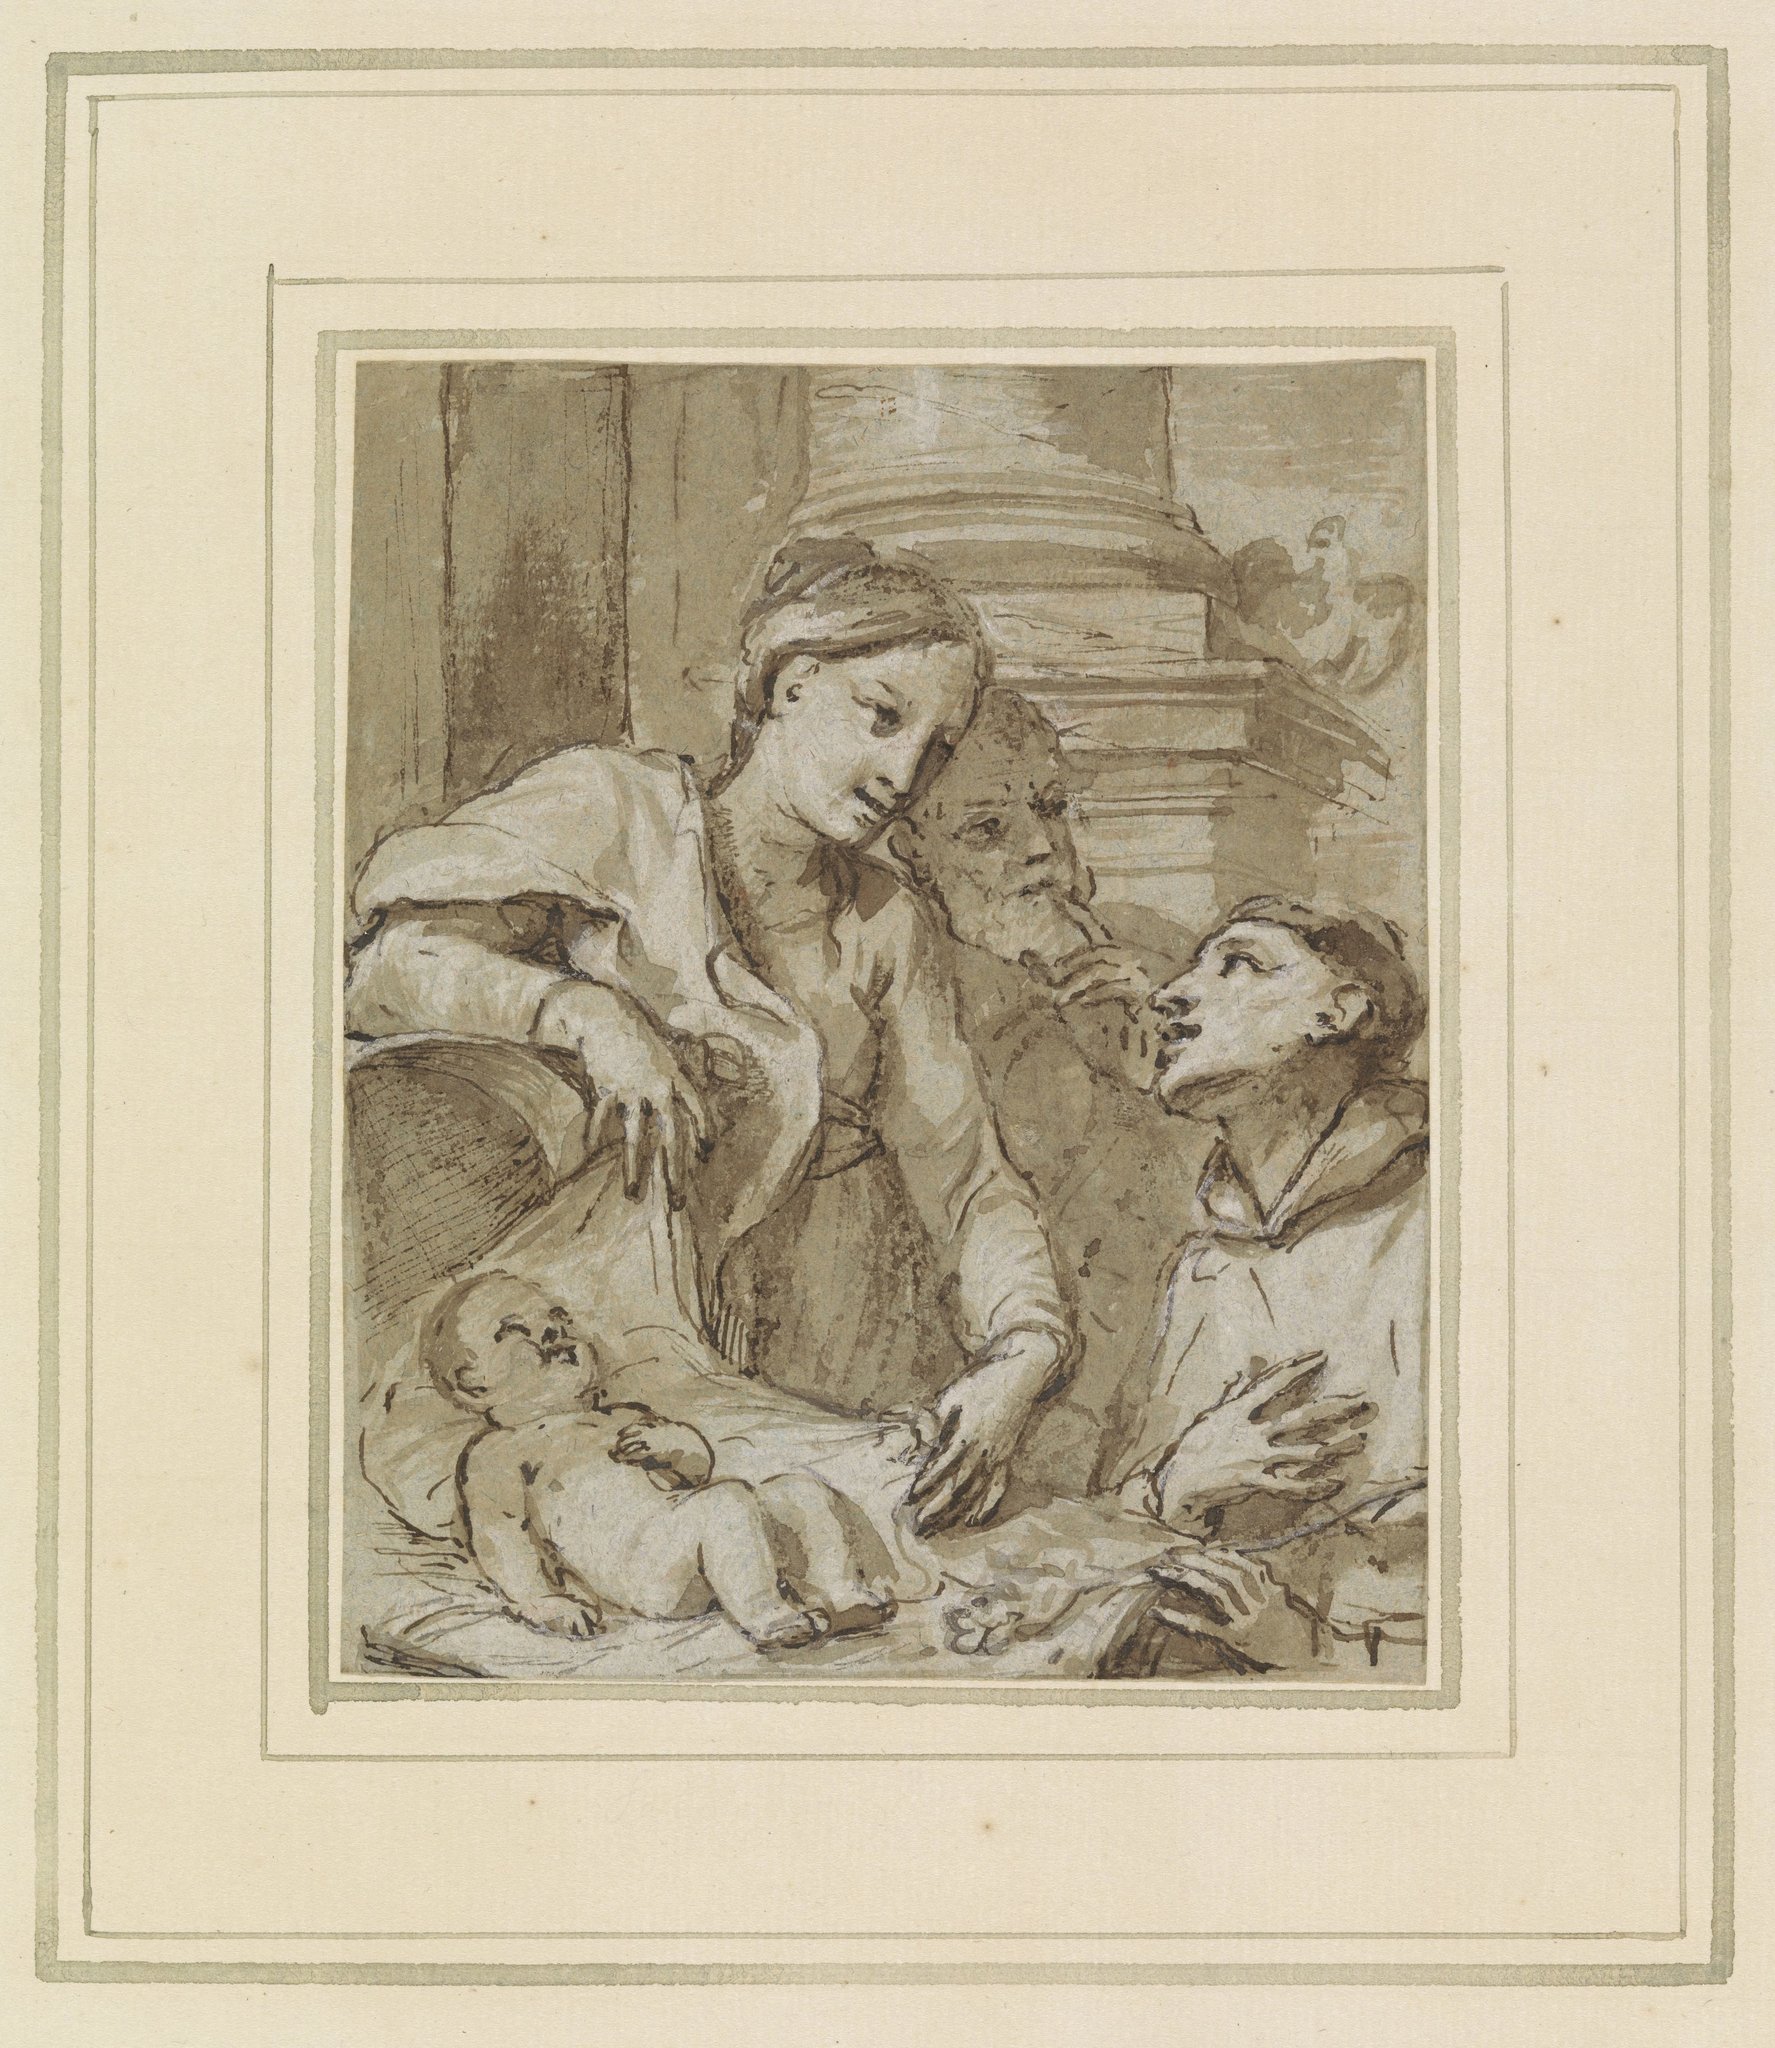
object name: drawing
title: Heilige Familie met de heilige Antonius van Padua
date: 1600-1699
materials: paint, ink, paper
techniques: brush, pen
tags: holy family with others, e.g.: anna, the franciscan monk antony of padua; possible attributes: ass, book, crucifix, flowered cross, flaming heart, infant christ (on book), lily